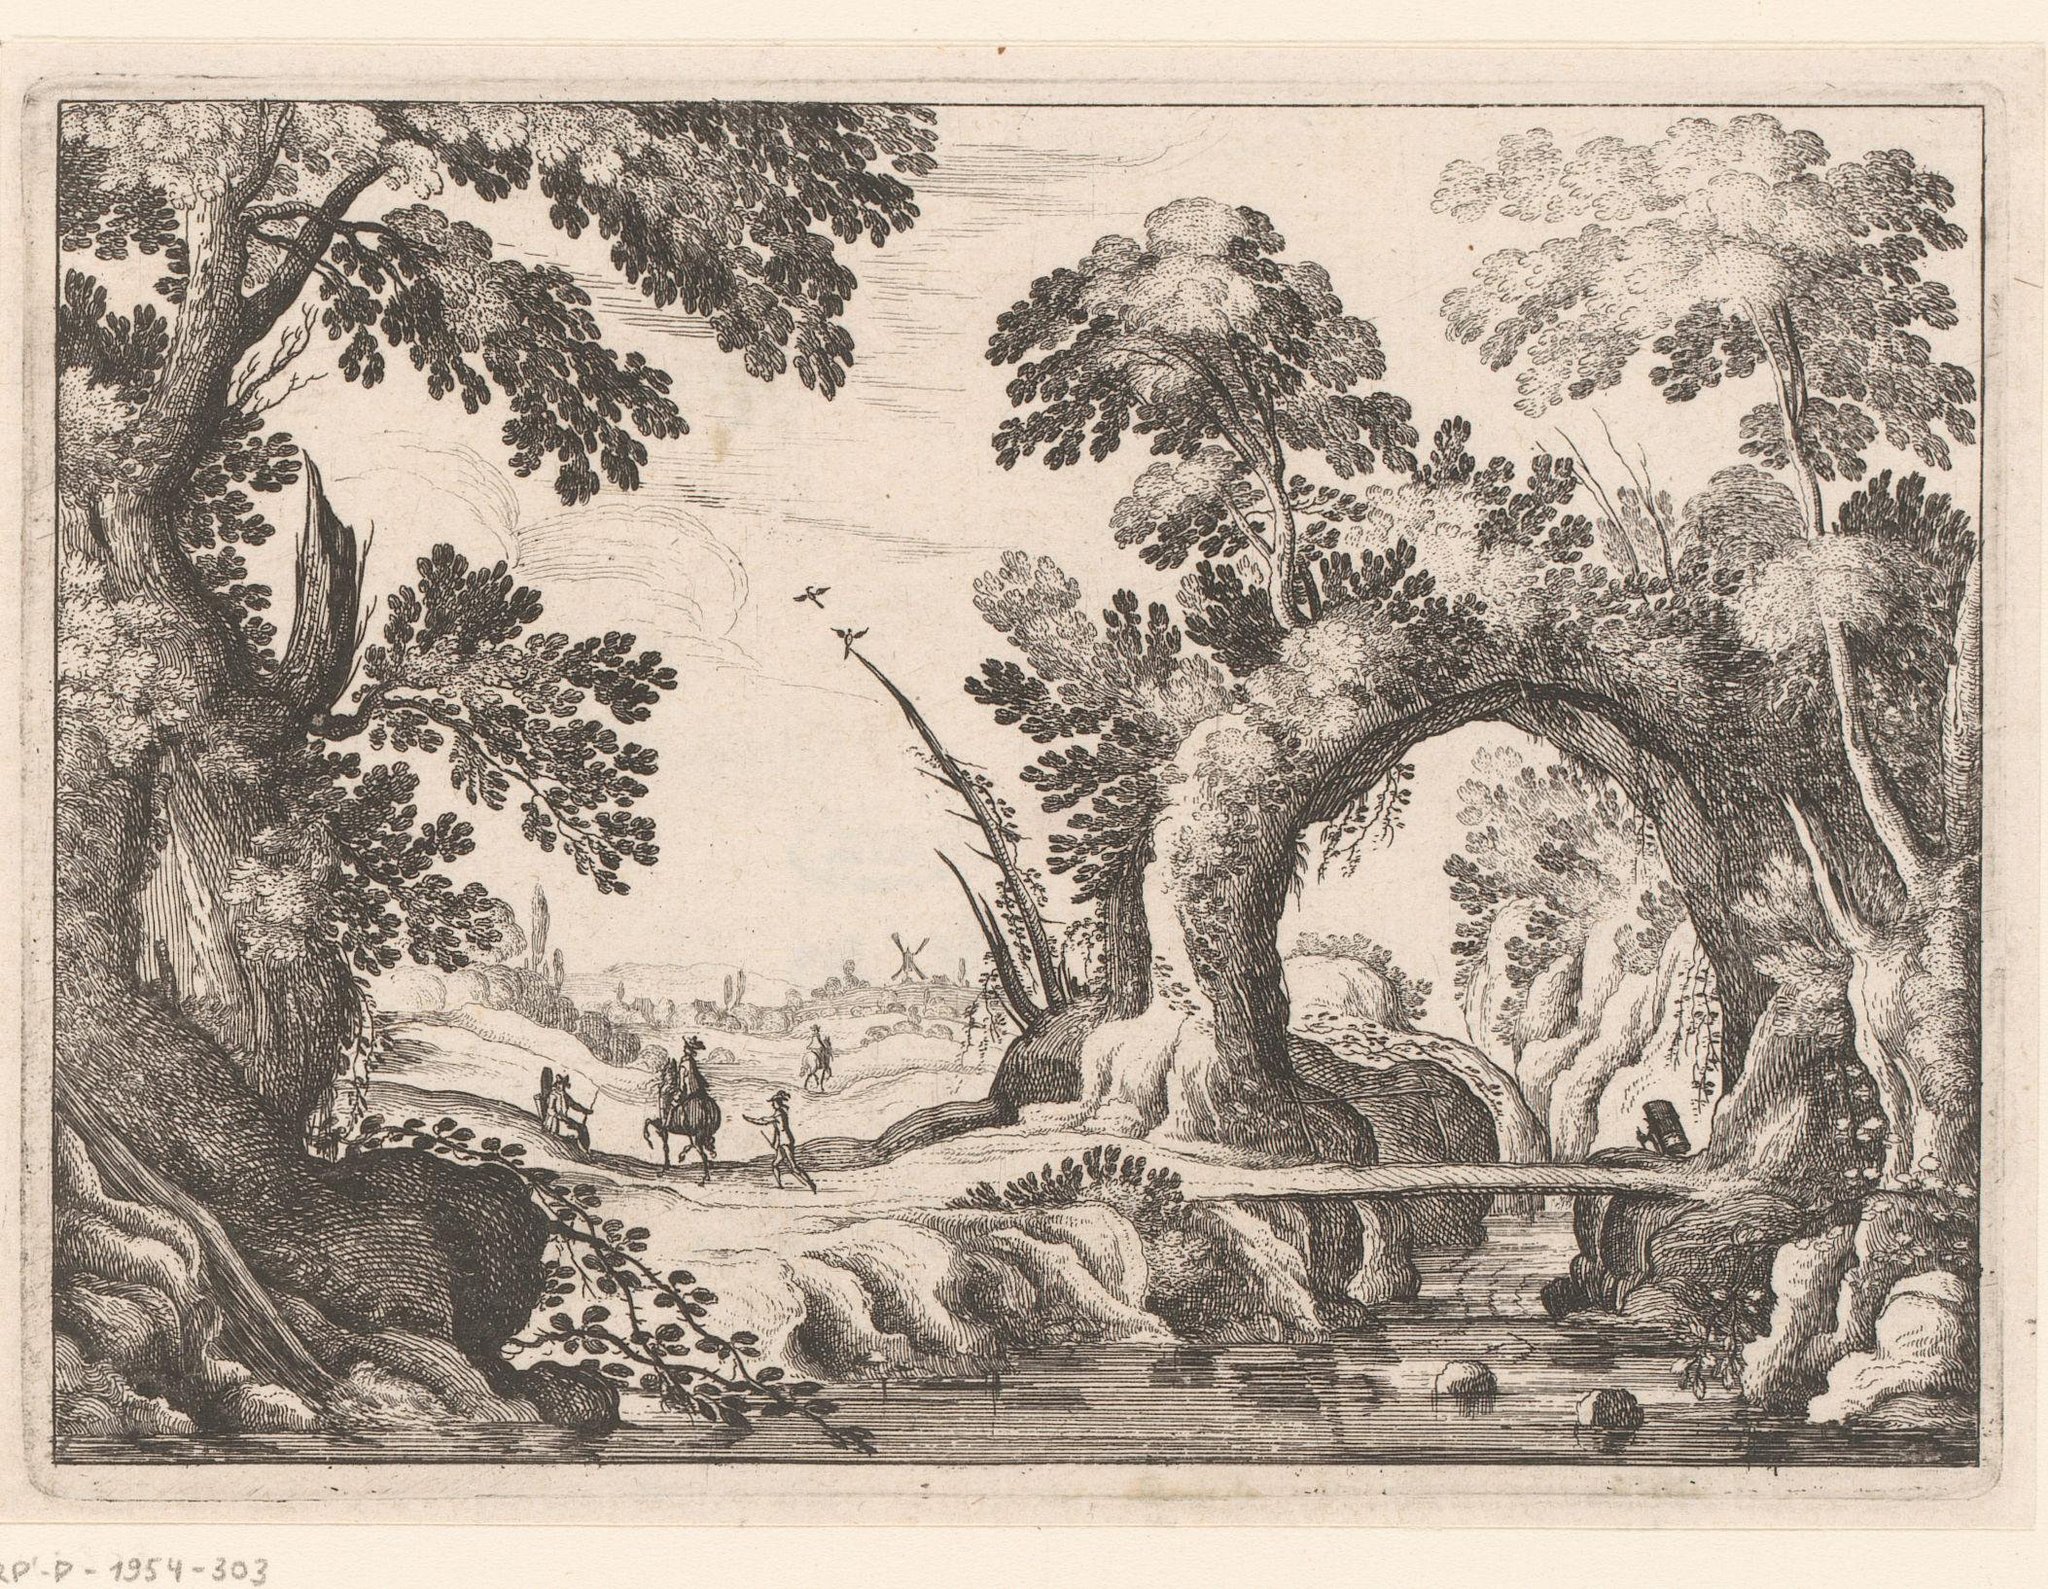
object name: print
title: Landschap met brug over rivier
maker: nicolas cochin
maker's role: print maker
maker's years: 1610-1686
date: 1620-1686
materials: paper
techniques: engraving, etching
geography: france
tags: riding a horse, ass, or mule; rider, horseman, landscape with bridge, viaduct or aqueduct, 'en route', traveller under way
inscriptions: collector's mark: Lugt 2228, collector's mark: Lugt 2760